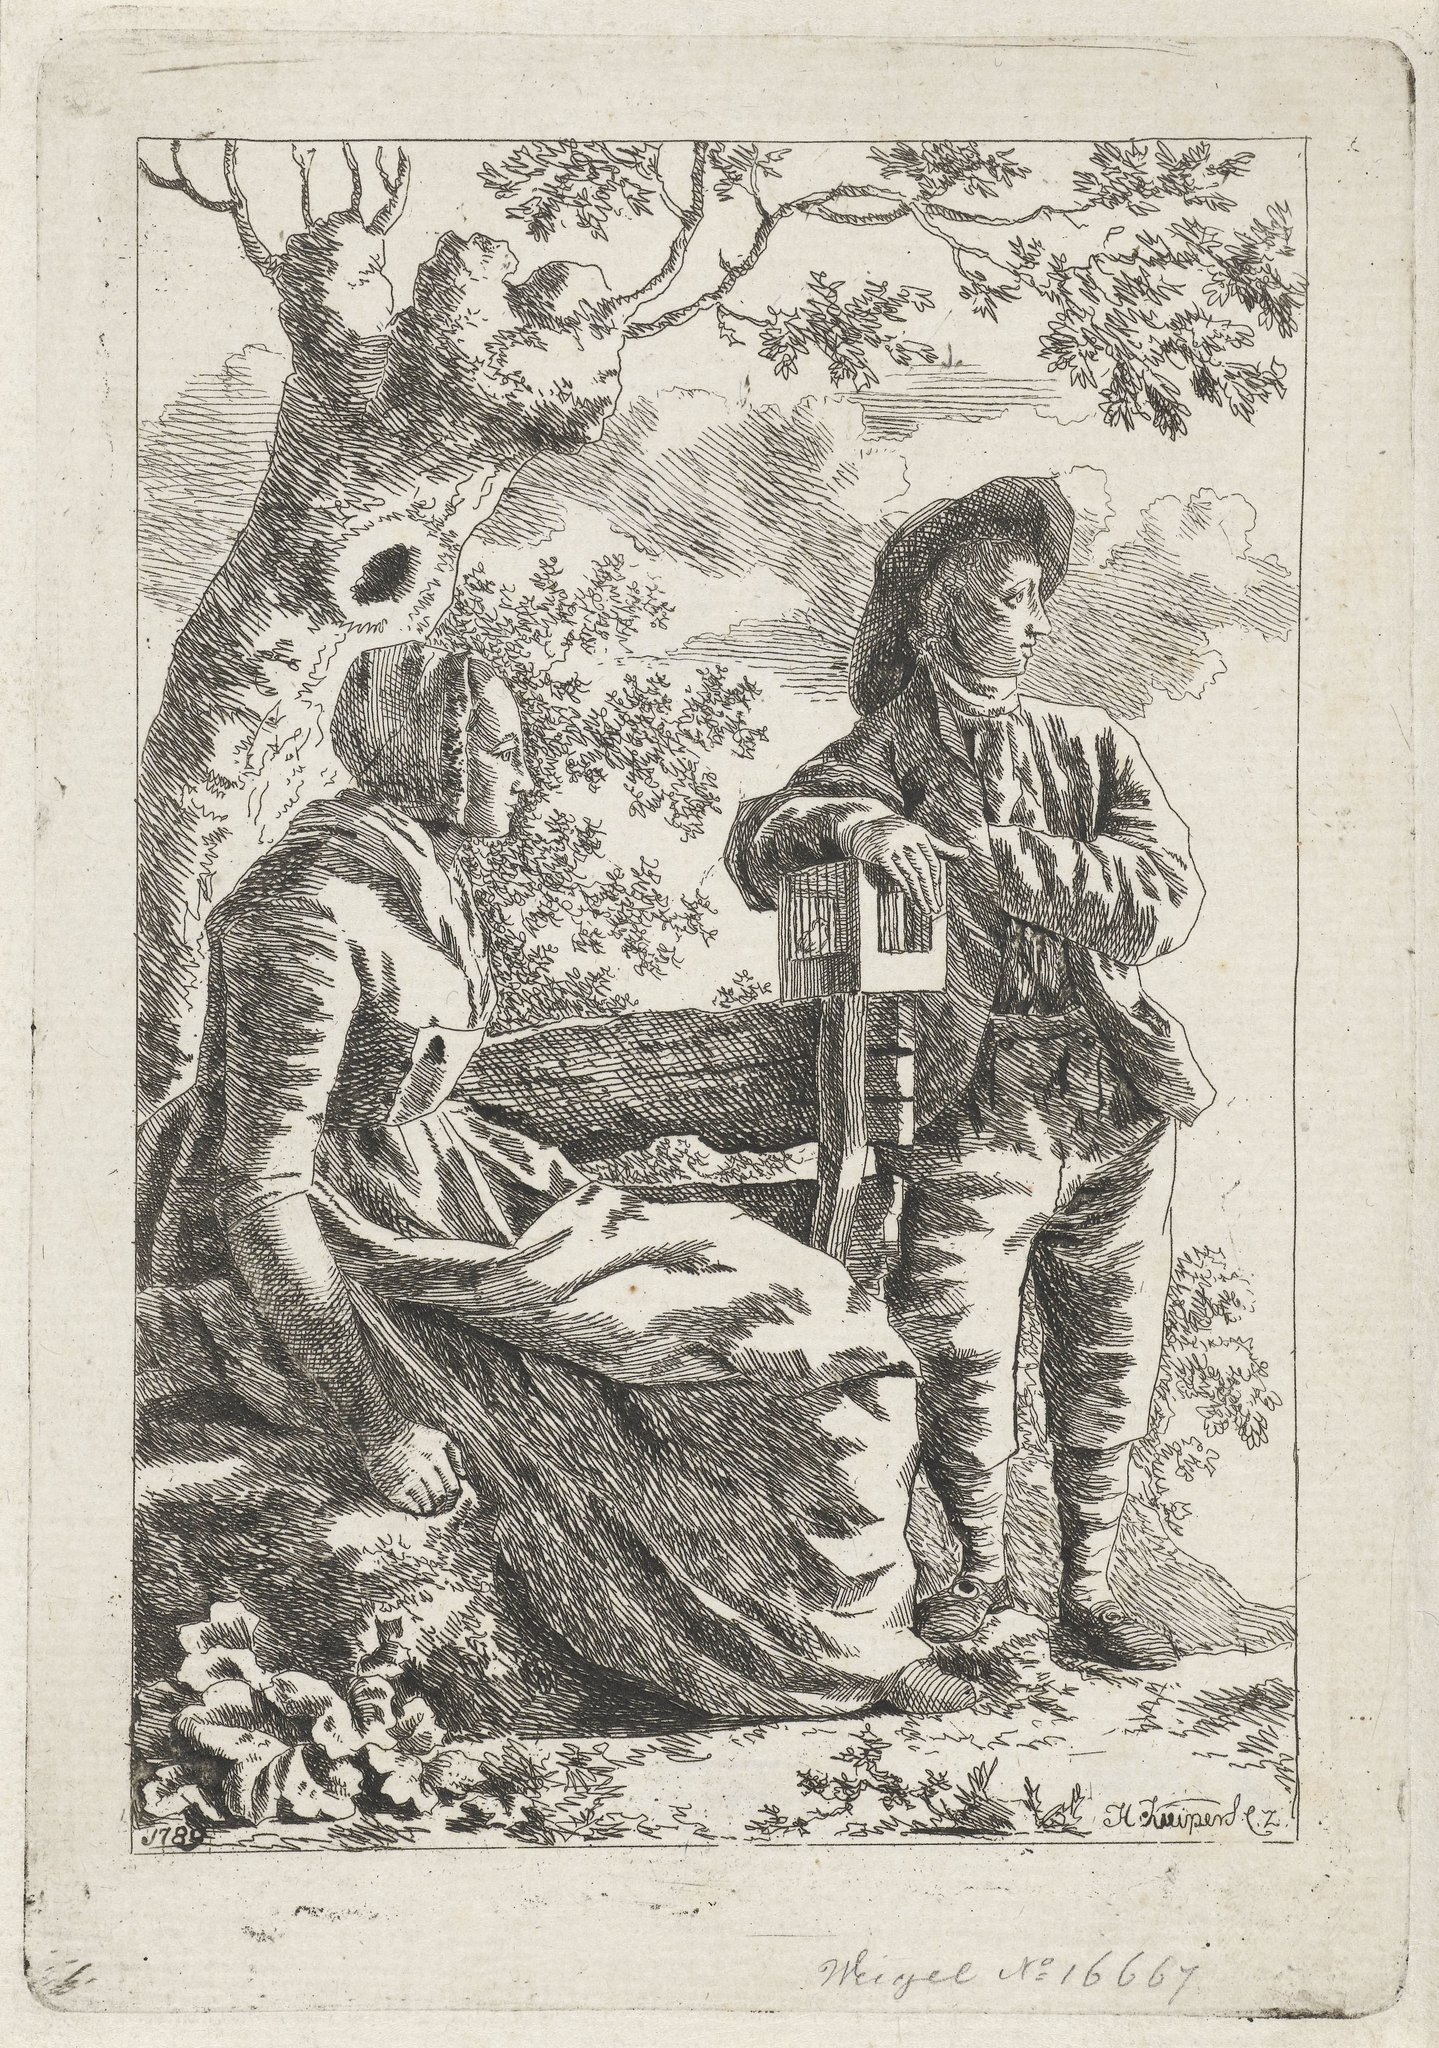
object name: print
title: Man en een vrouw bij een boom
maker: hendrik kuipers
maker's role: print maker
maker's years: 1764-1798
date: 1789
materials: paper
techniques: etching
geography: dordrecht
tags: trees, bird in a cage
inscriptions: inscription: ‘Weigel N 16667’, collector's mark: Lugt 2228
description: In een landschap bij een boom zit een vrouw met een kapje op haar hoofd. Naast haar staat een man die zijn rechterarm op een vogelkooi laat rusten en zijn hand voor het vogelhuisje houdt.